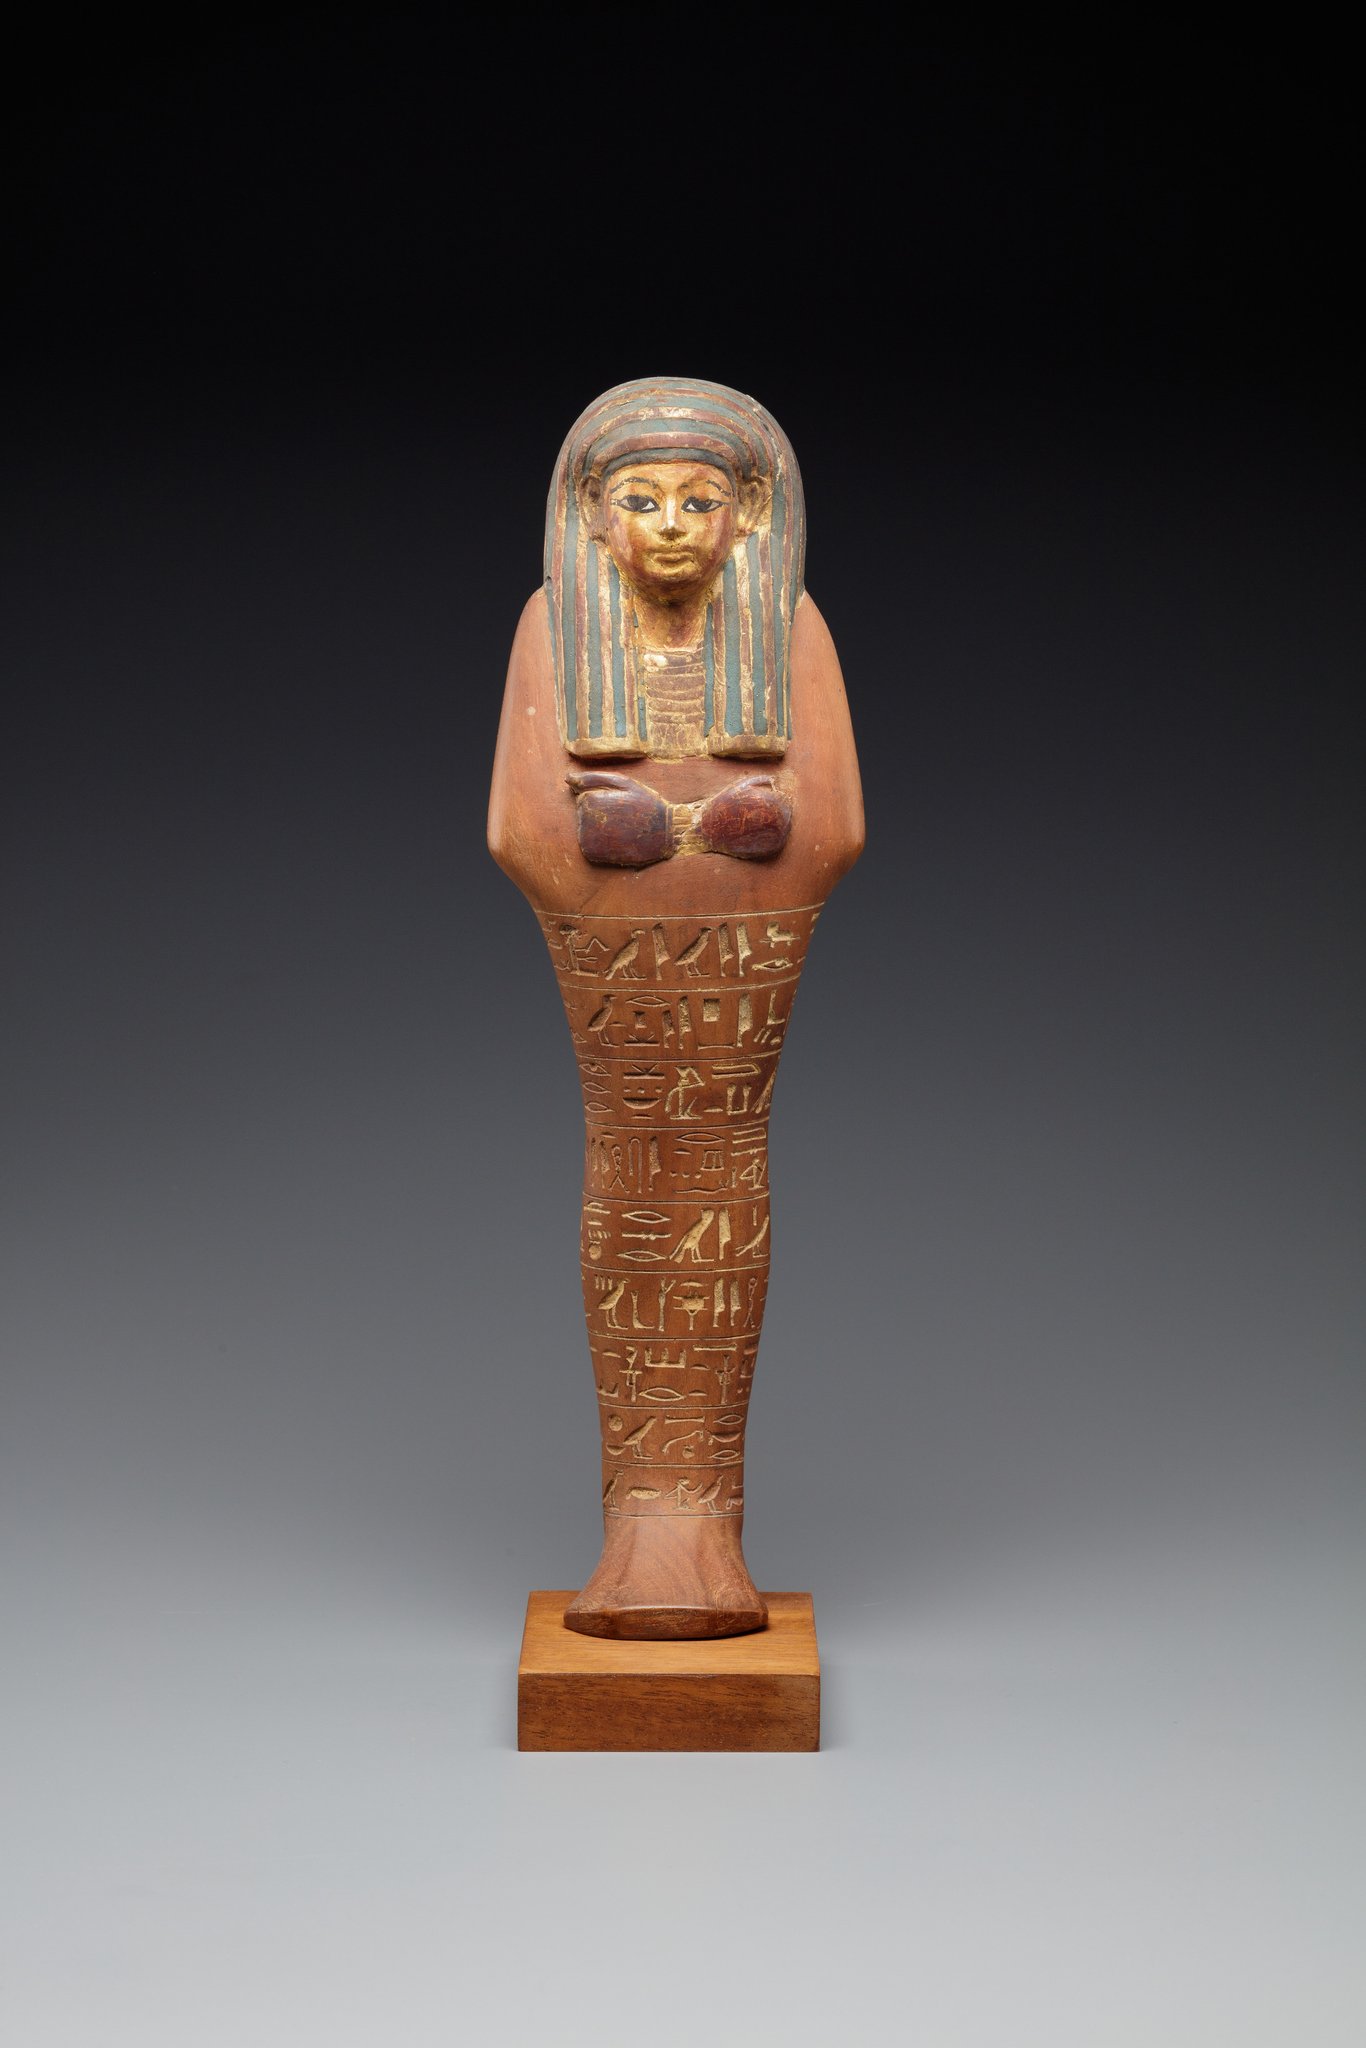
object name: shabti, yuya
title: Shabti of Yuya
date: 1390-1352 BCE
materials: wood, gold, paint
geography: egypt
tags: hieroglyphs